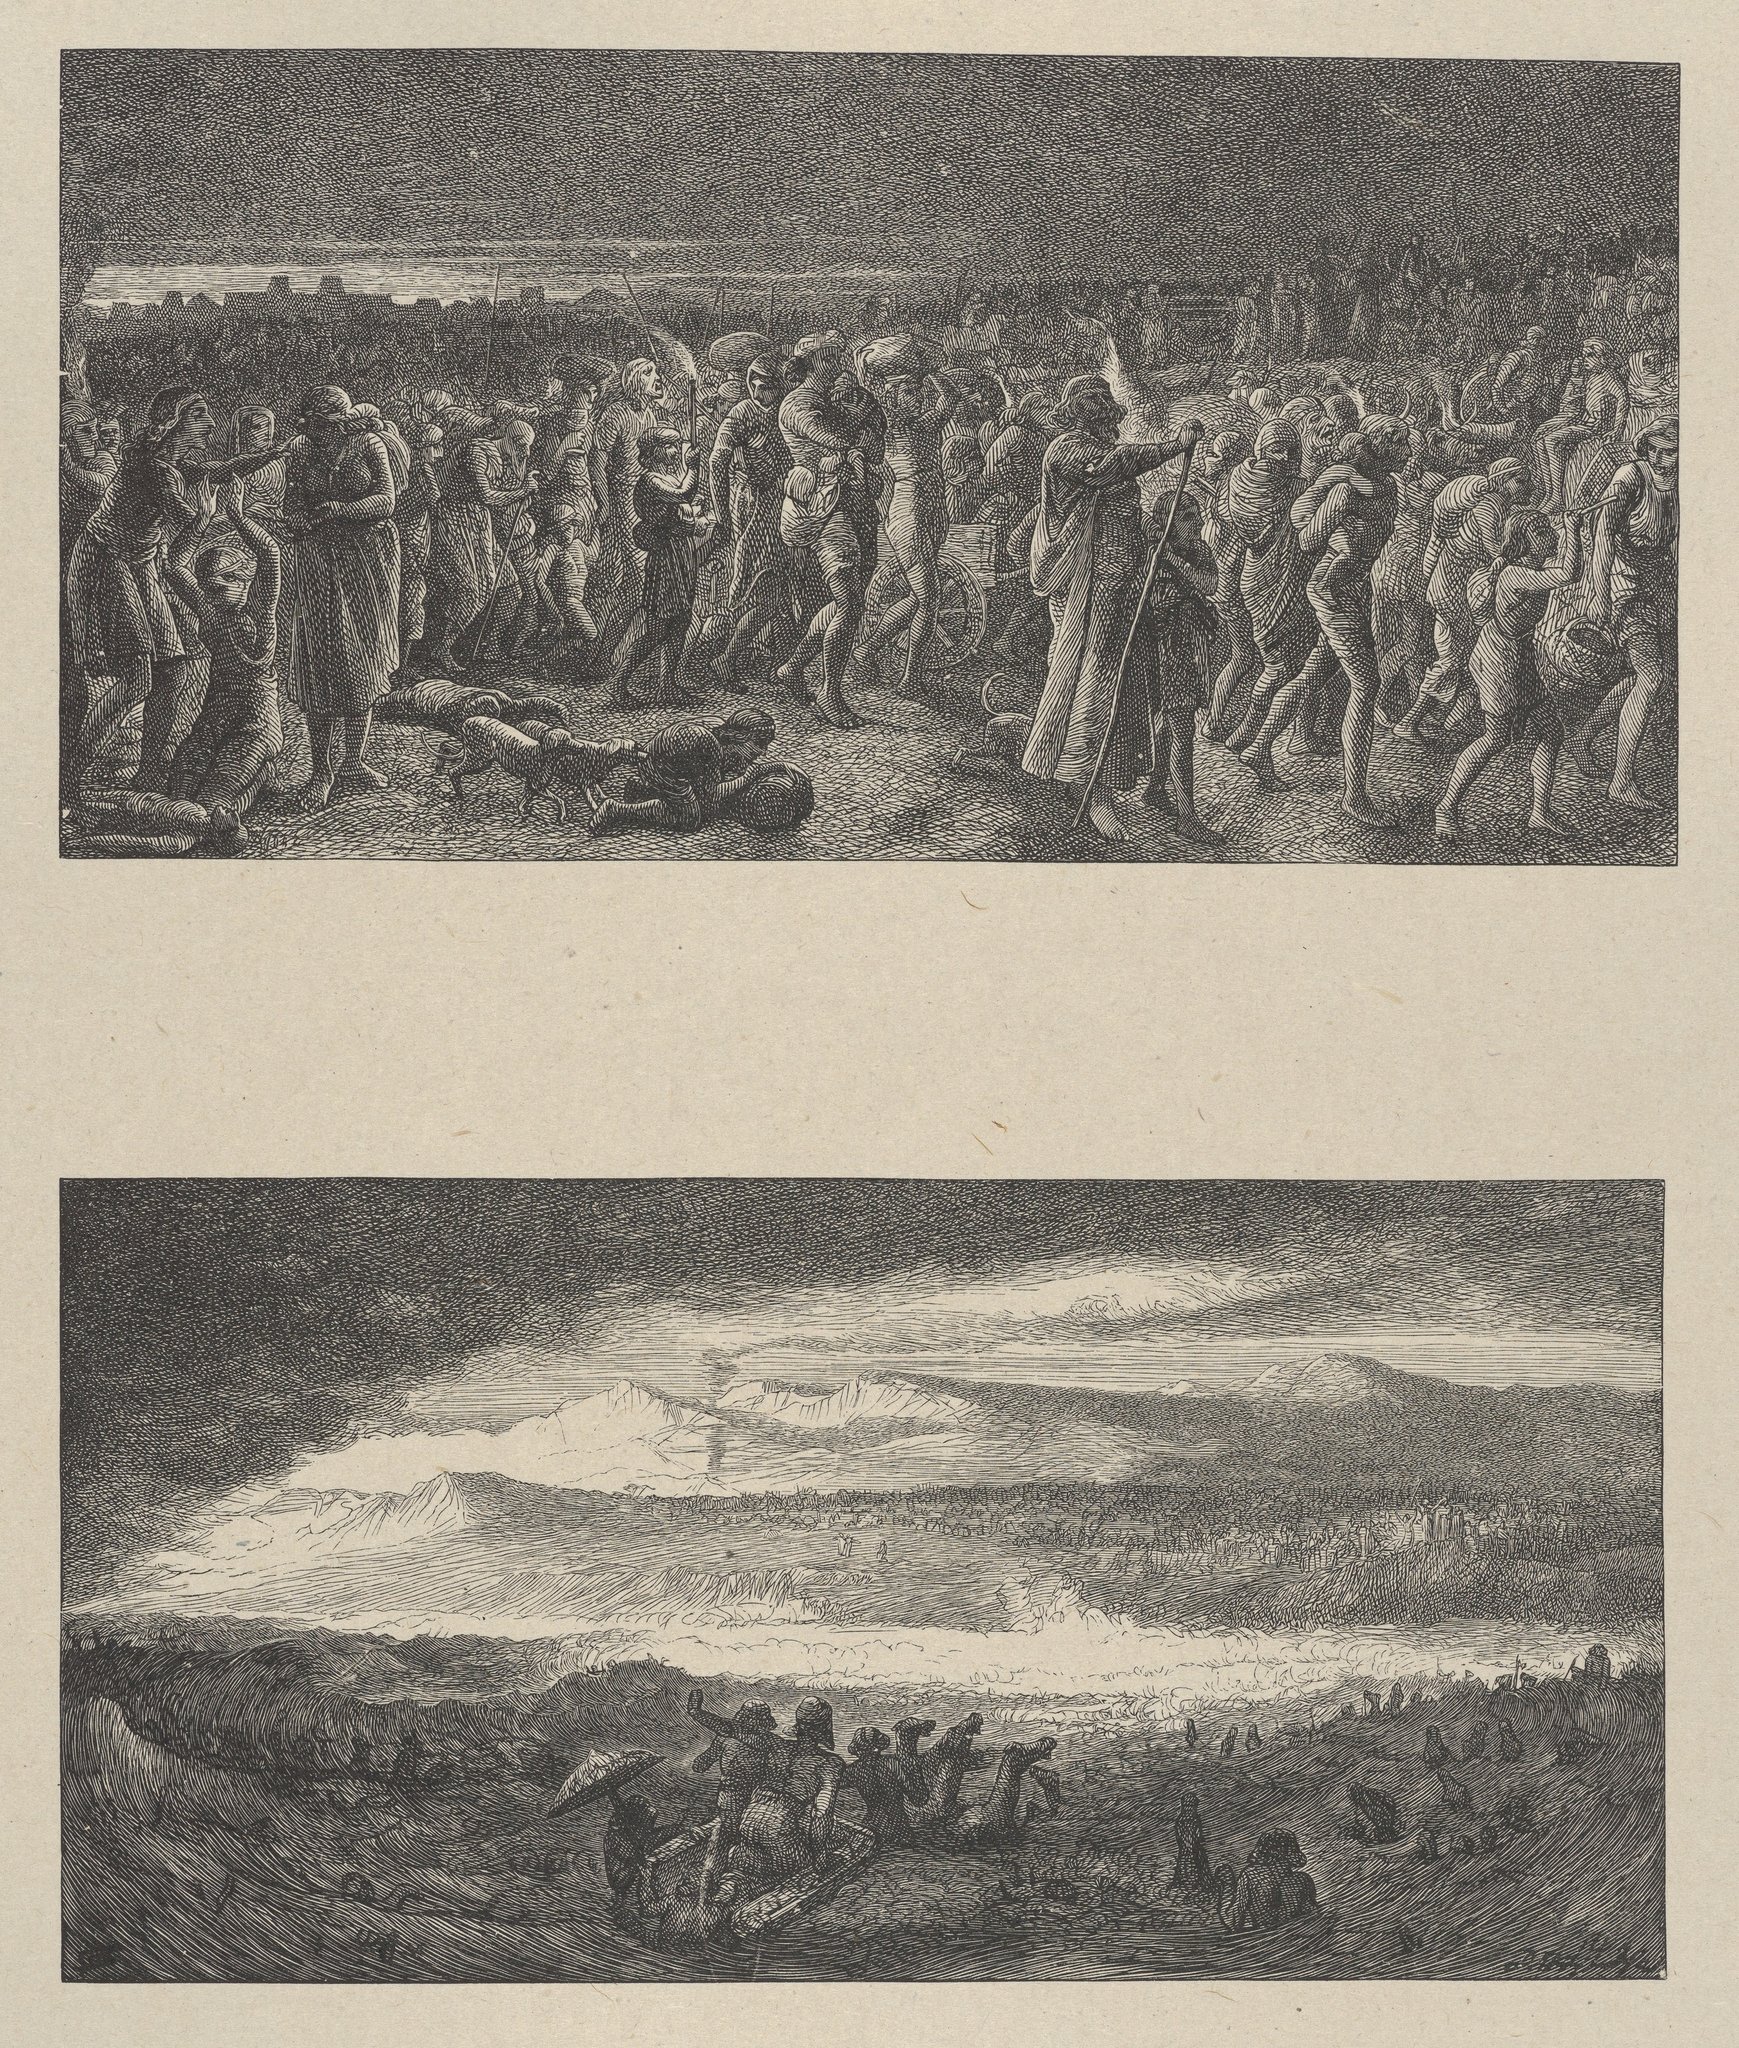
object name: print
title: The Departure of the Israelites–Destruction of Pharoah and His Host, from "Dalziels' Bible Gallery"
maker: thomas dalziel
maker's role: artist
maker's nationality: british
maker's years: 1823-1906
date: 1865-1881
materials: paper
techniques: engraving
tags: animals,crowd